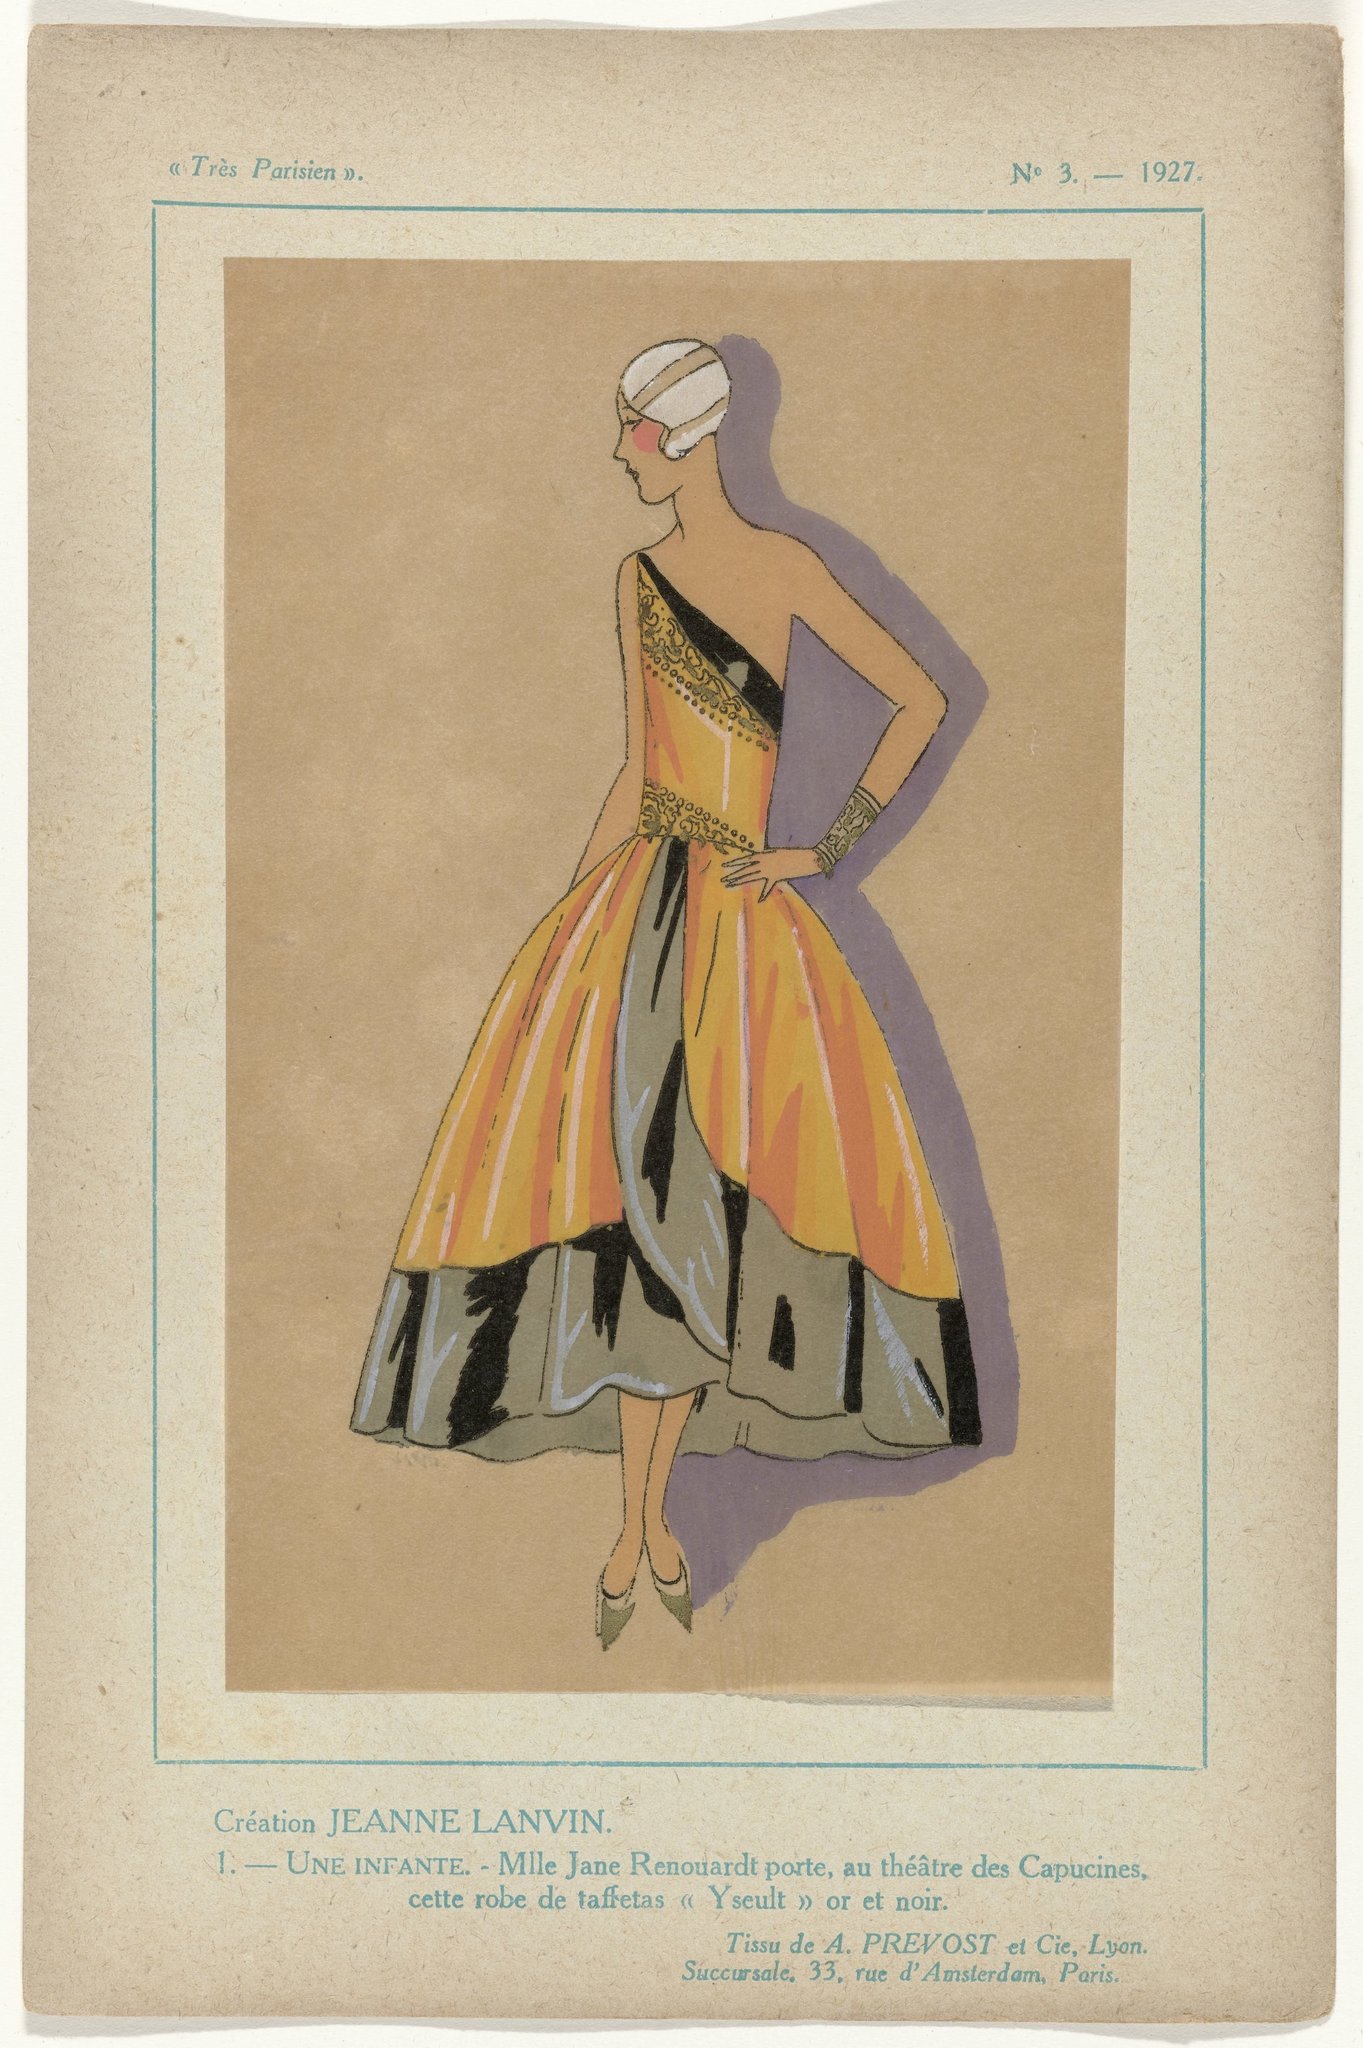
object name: fashion print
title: Très Parisien. La Mode, Le Chic, L’Elégance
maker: g-p. joumard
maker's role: publisher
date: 1927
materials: paper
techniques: hand coloring, letterpress printing, lithography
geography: paris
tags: dress, gown: evening dress (+ women's clothes), fashion plates, bracelet, wristlet (+ women's clothes)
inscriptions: caption: ‘UNE INFANTE. - Mlle Jane Renouardt porte, au théatre des Capucines, cette robe de taffetas "Yseult" or et noir.’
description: Très Parisien promoted itself as chic and elegant. Between 1920 and 1936 it presented creations by such couturiers as Chéruit, Premet, Philip et Gaston, and Lanvin. The young, svelte models are all ultra-modern, shown talking on the phone, smoking and playing tennis. The illustrations also show that over the course of the 1920s, skirt lengths had risen to just below the knee, before dropping back down to calf length in the 1930s. The small plates were printed on transparent paper using a stencilling technique known as en pochoir and then hand coloured; many of them are unsigned. The signature ‘Joujou’ belonged to Germaine Paule Joumard, who was the director of Très Parisien, as well as one of the magazine’s illustrators.